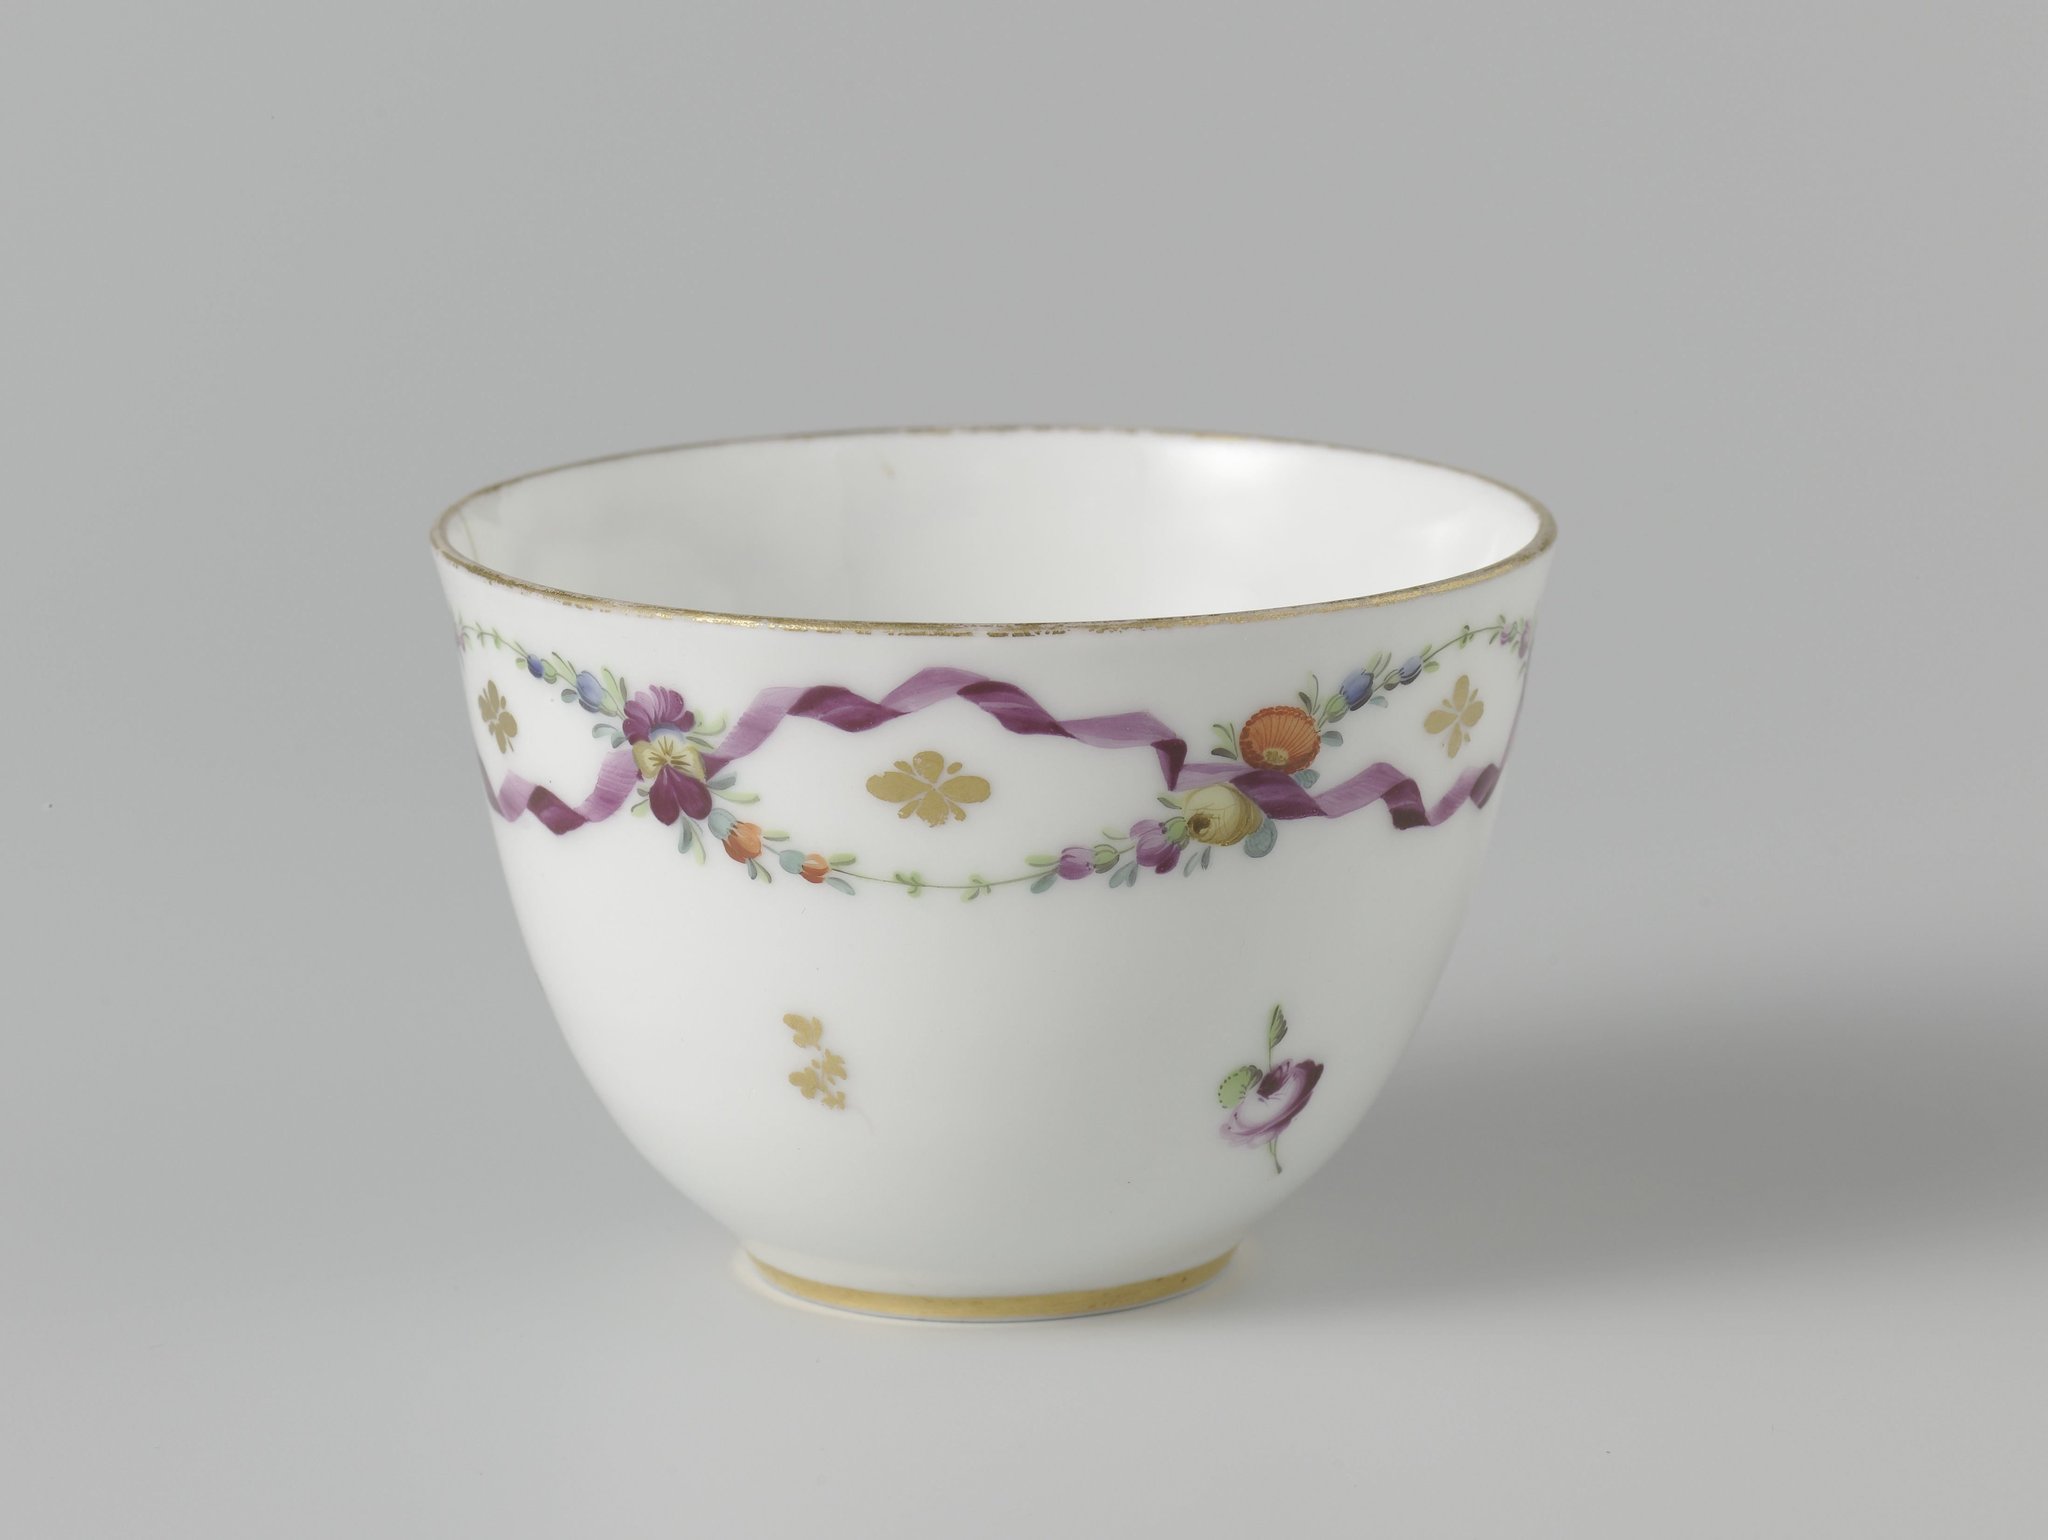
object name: cup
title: Kop zonder oor, beschilderd met strooibloemen en gouden lovertjes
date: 1809-1814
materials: porcelain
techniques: painted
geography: nieuwer-amstel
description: Tea service. Porcelain. Ouder-Amstel, c. 1790 - 1800. Factory under the direction of Friedrich Daeuber. Given by Mr and Mrs J.F. Heijbroek-Leendertz, 1985.